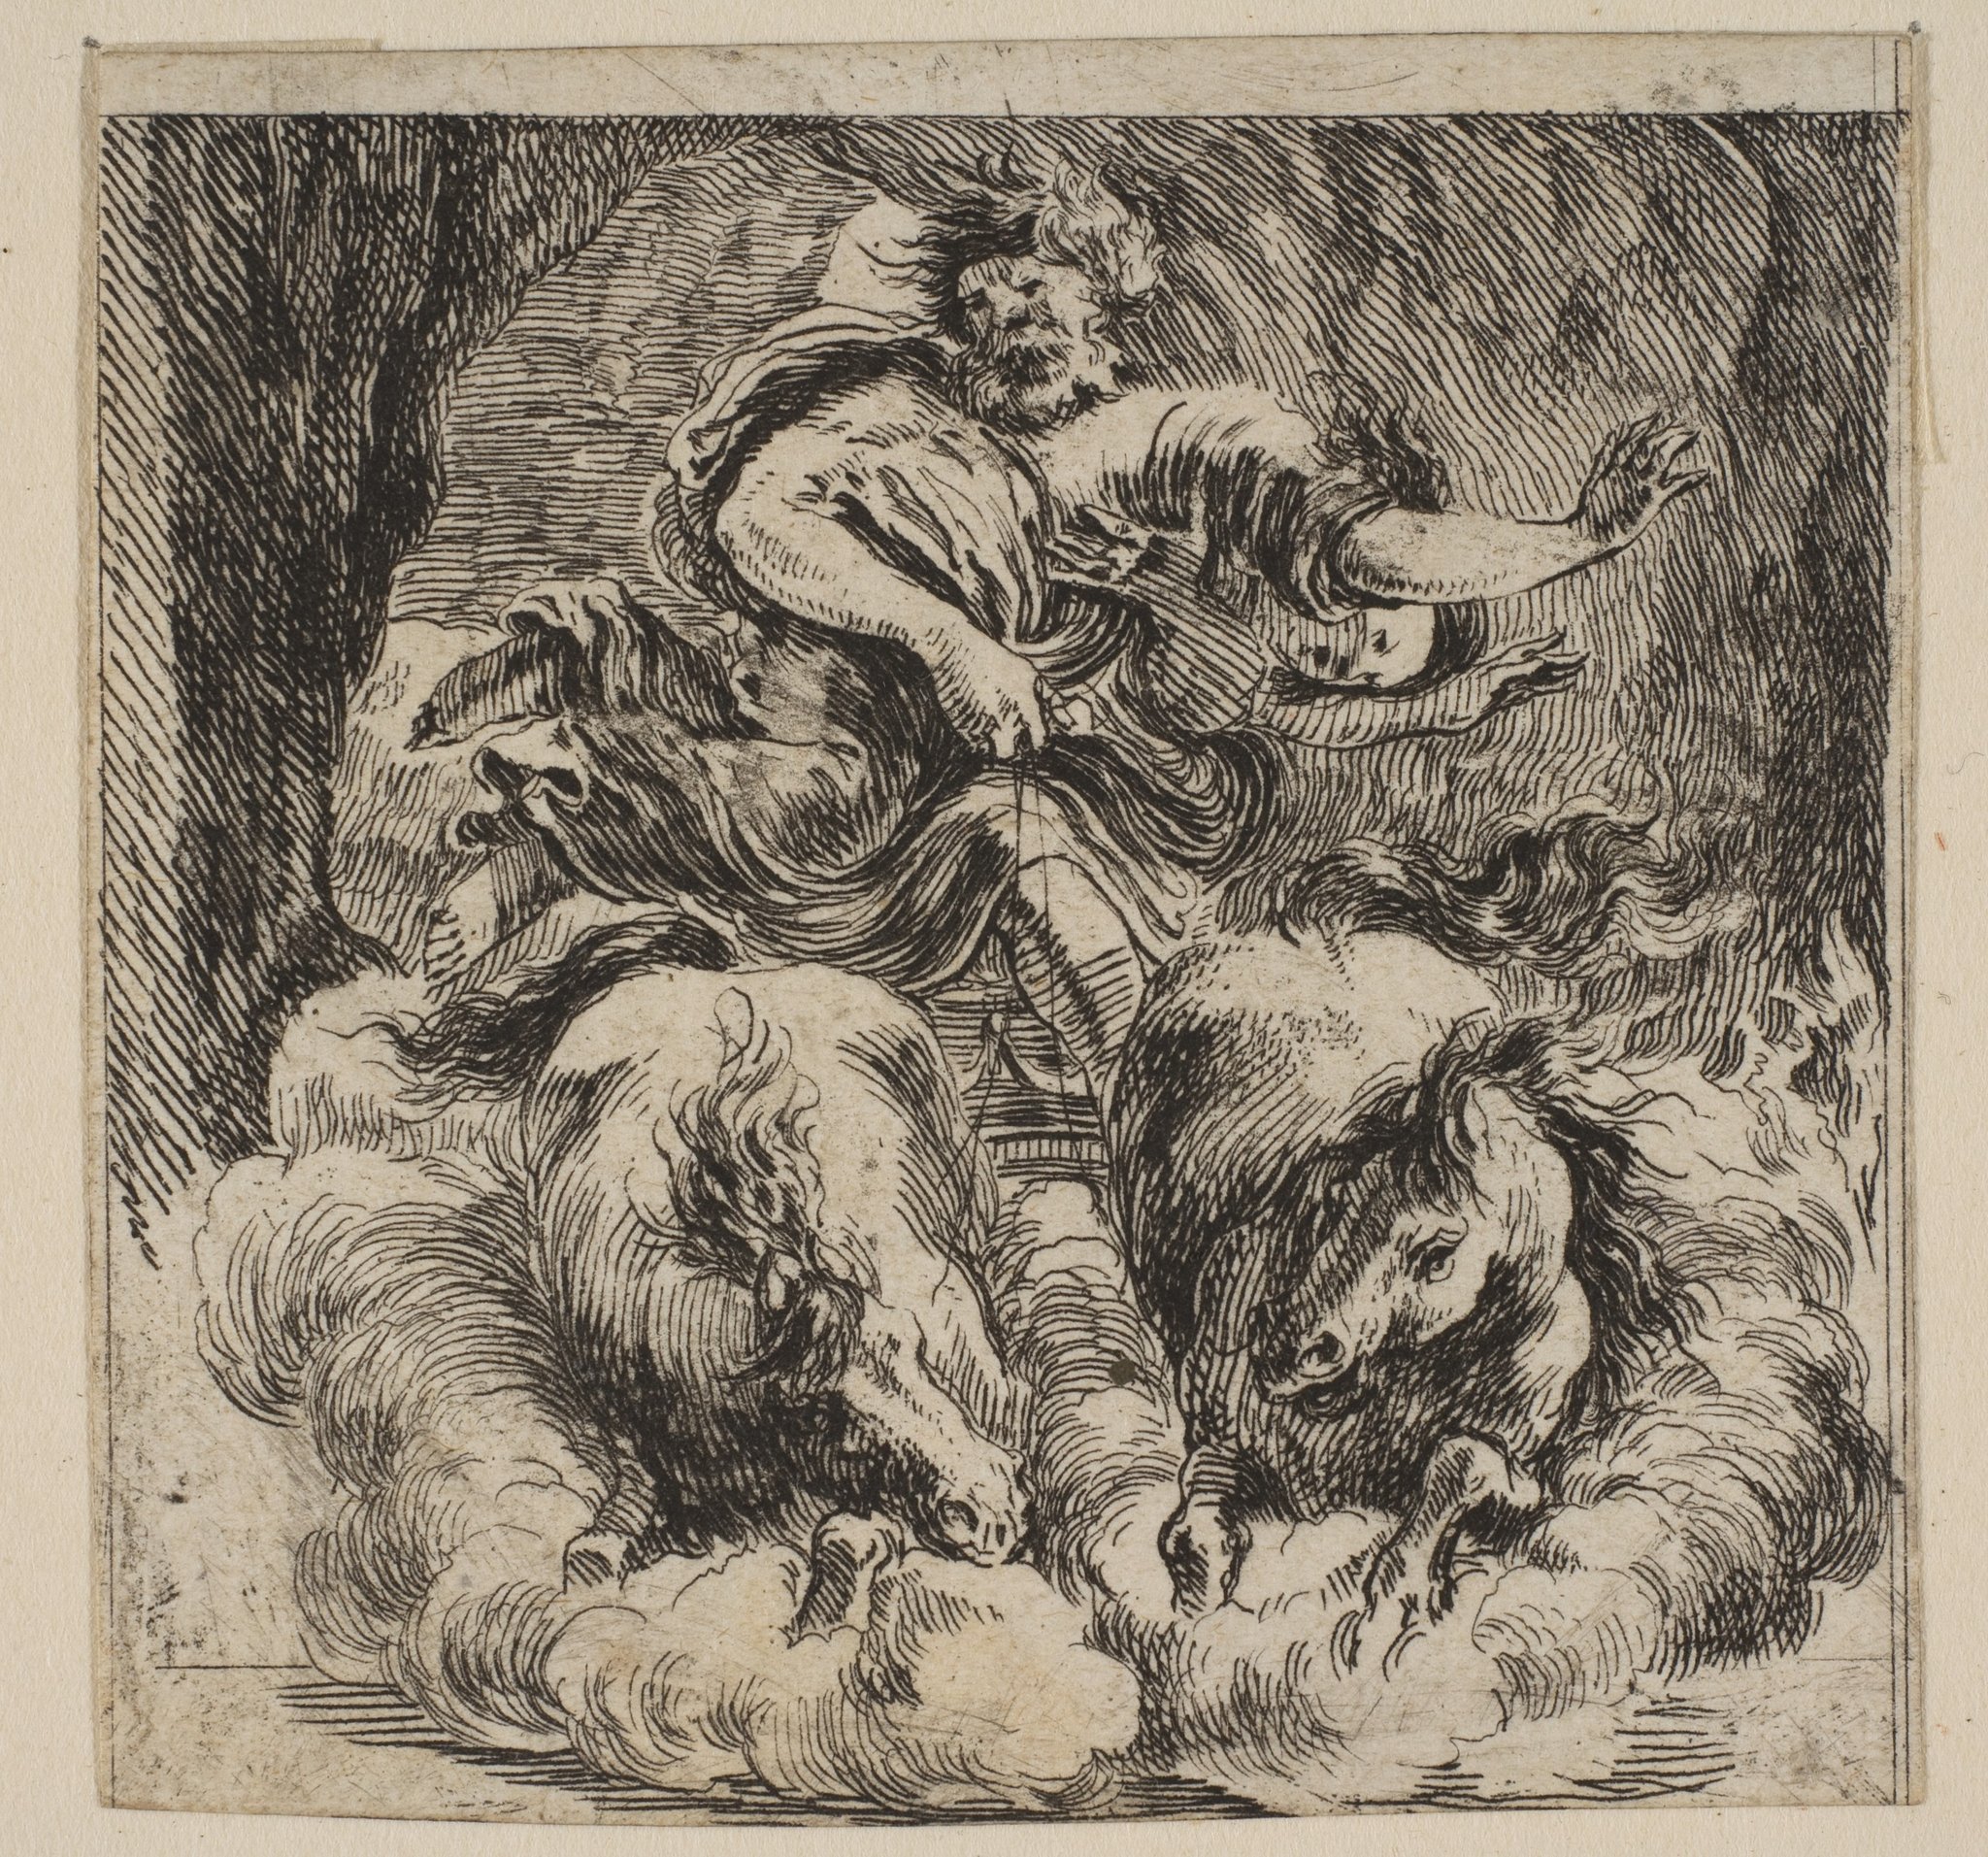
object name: print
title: Proserpina, from 'Game of Mythology' (Jeu de la Mythologie)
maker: stefano della bella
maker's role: artist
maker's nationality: italian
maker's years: 1610-1664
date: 1644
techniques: etching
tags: men,horses,goddess